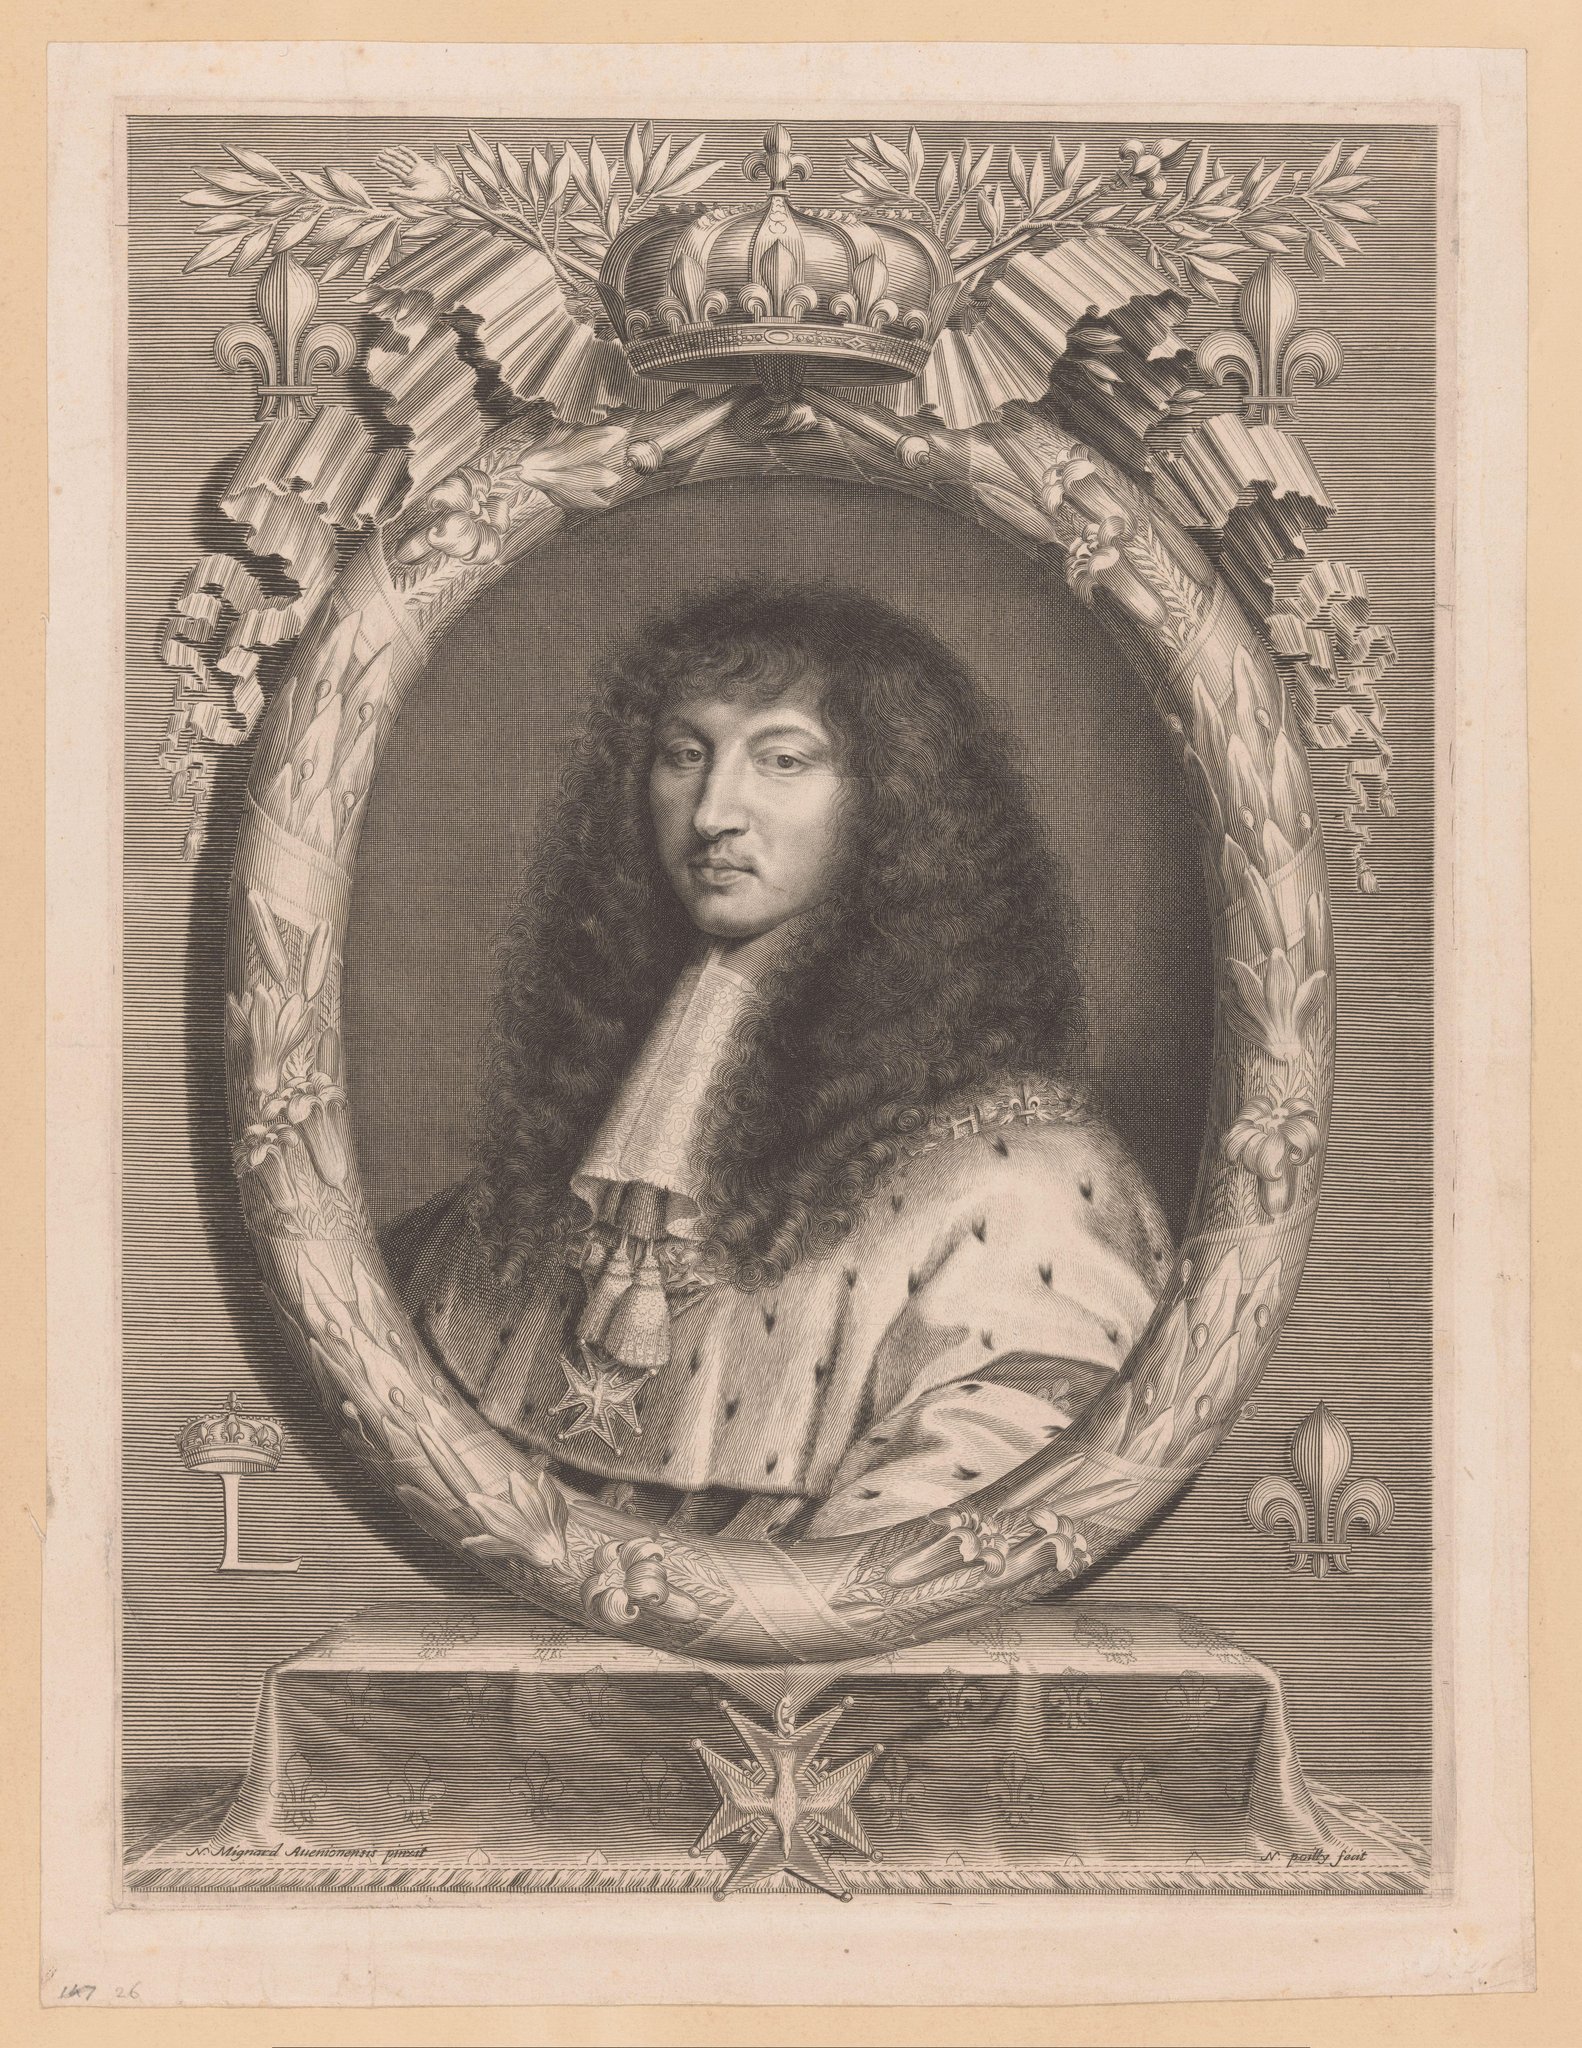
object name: print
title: Portret van Lodewijk XIV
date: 1636-1696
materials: paper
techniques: engraving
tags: lodewijk xiv (koning van frankrijk), historical persons, king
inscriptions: collector's mark: Lugt 240